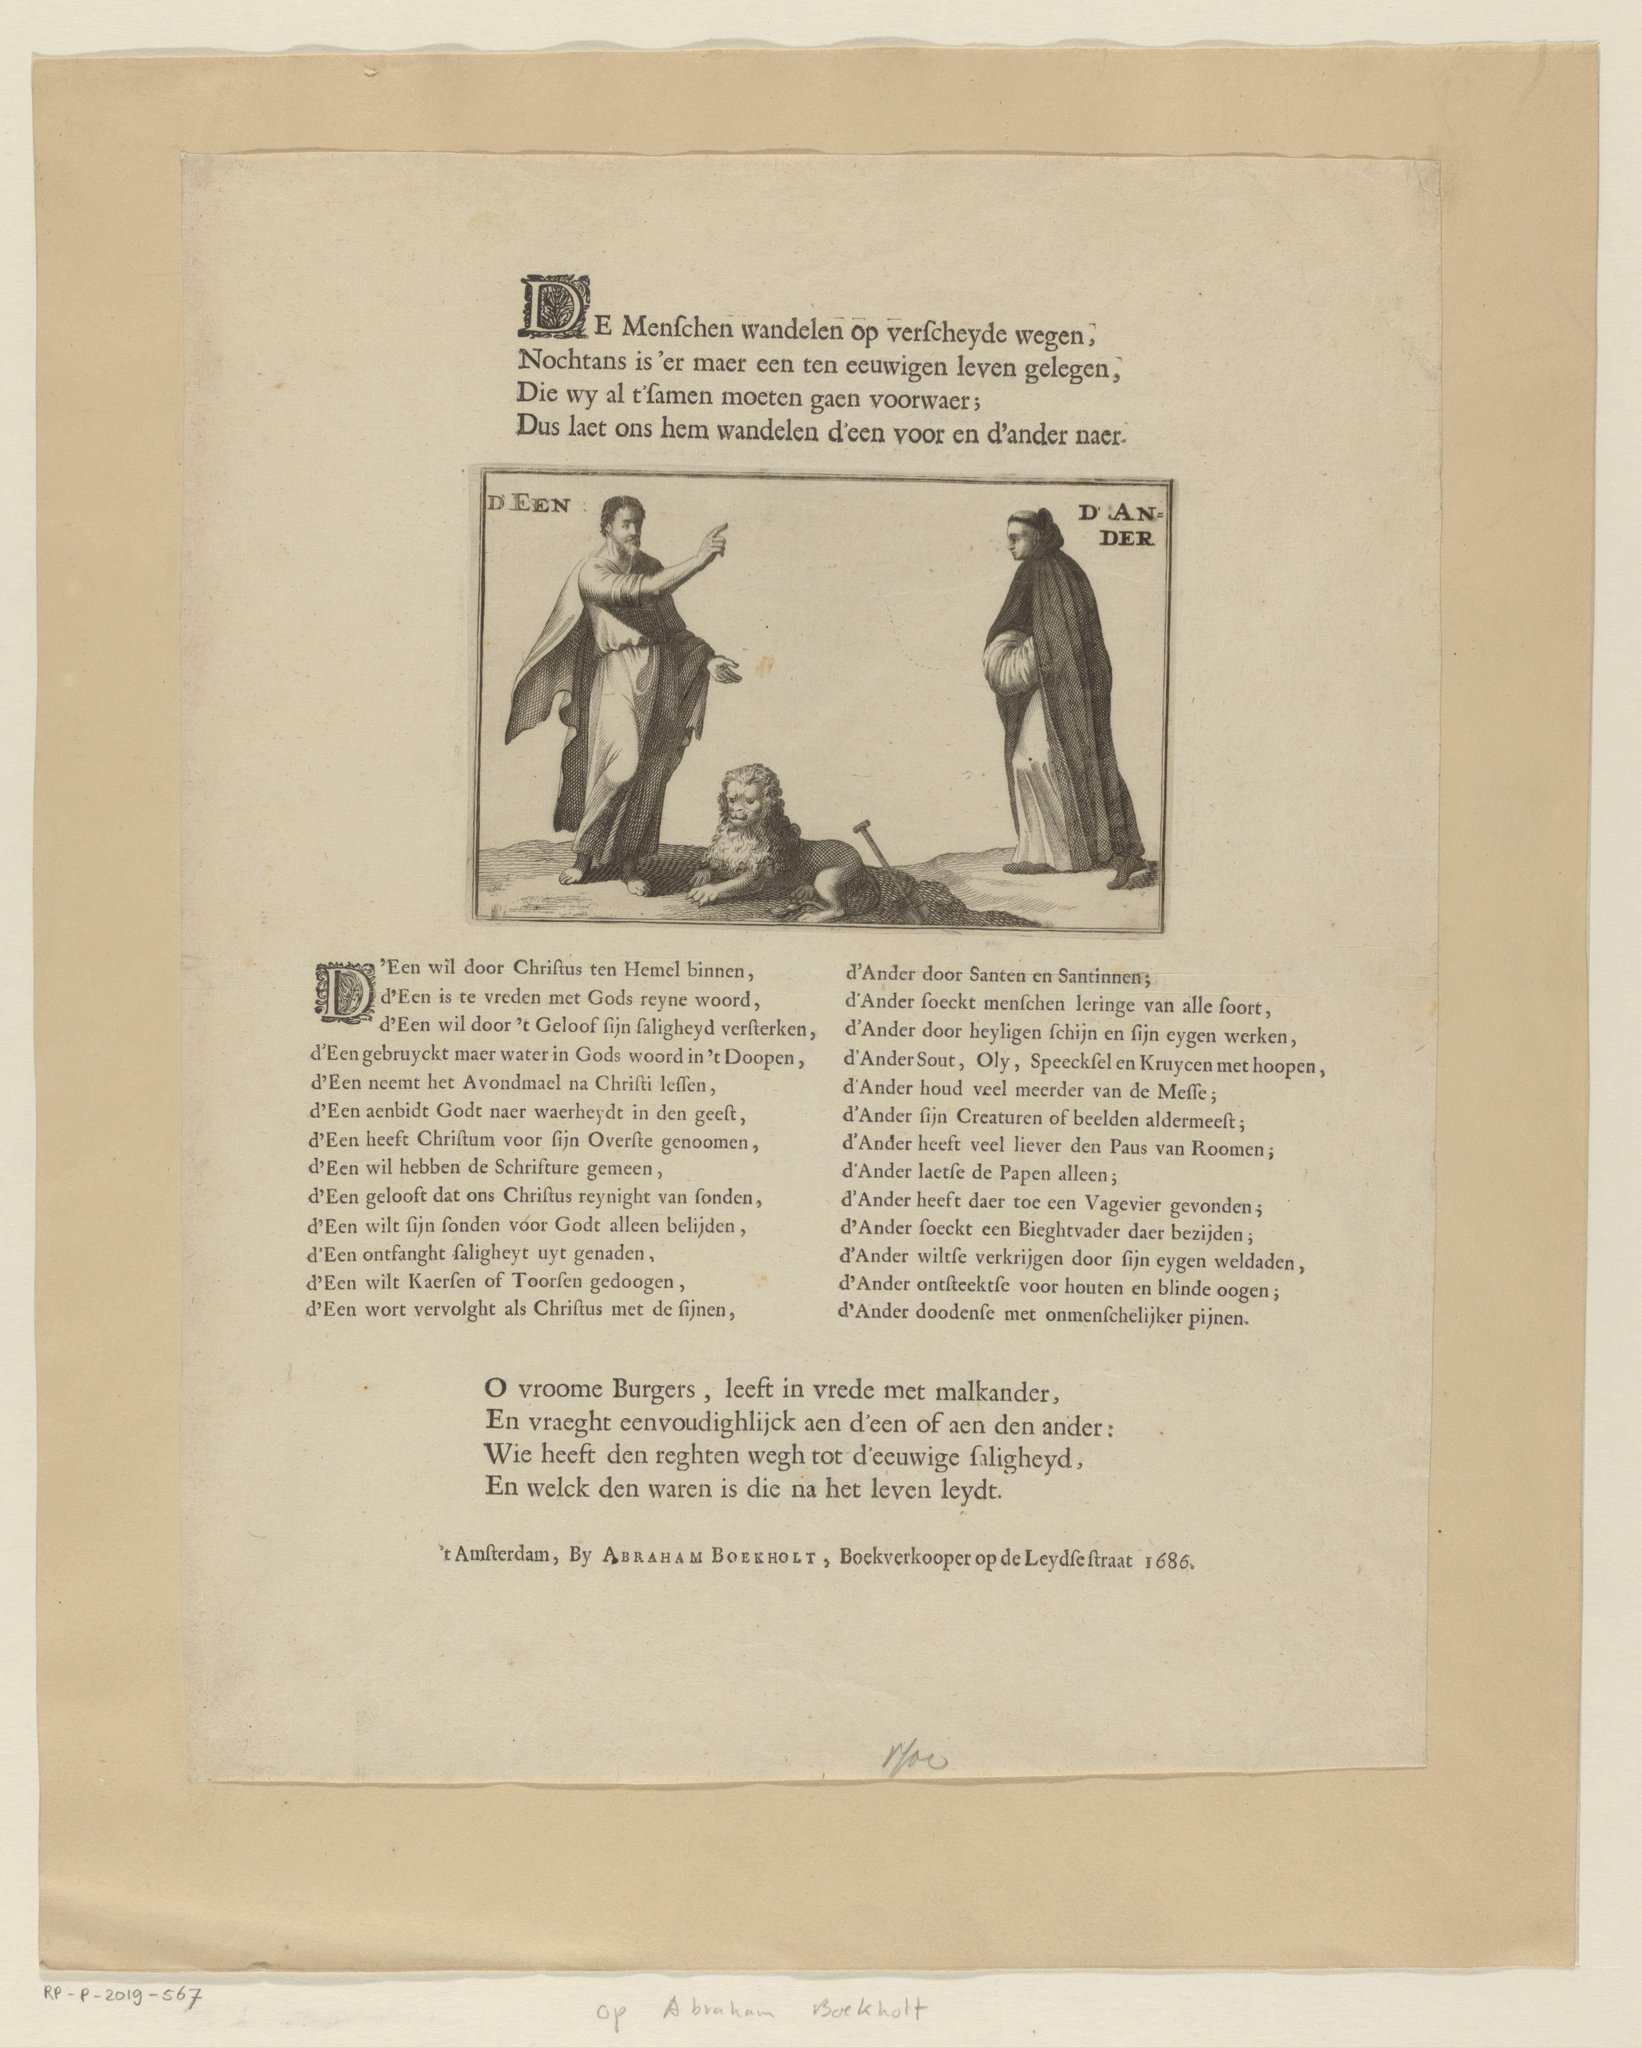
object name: print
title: Gedicht met twee mannen bij een leeuw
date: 1686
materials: paper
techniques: etching, letterpress printing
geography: netherlands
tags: protestant churches and denominations, roman catholic church, beasts of prey, predatory animals: lion, tolerance, long-suffering; 'longanimità', 'toleranza' (ripa)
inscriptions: watermark, collector's mark: Lugt 2228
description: 21-regelig gedicht, waarvan dertien regels in twee kolommen, met centraal een prent met twee mannen (katholiek en protestant) getiteld 'D'Een' en 'D'Ander' bij een leeuw met schep. Het gedicht roept op tot tolerantie en een vreedzaam leven naast elkaar.